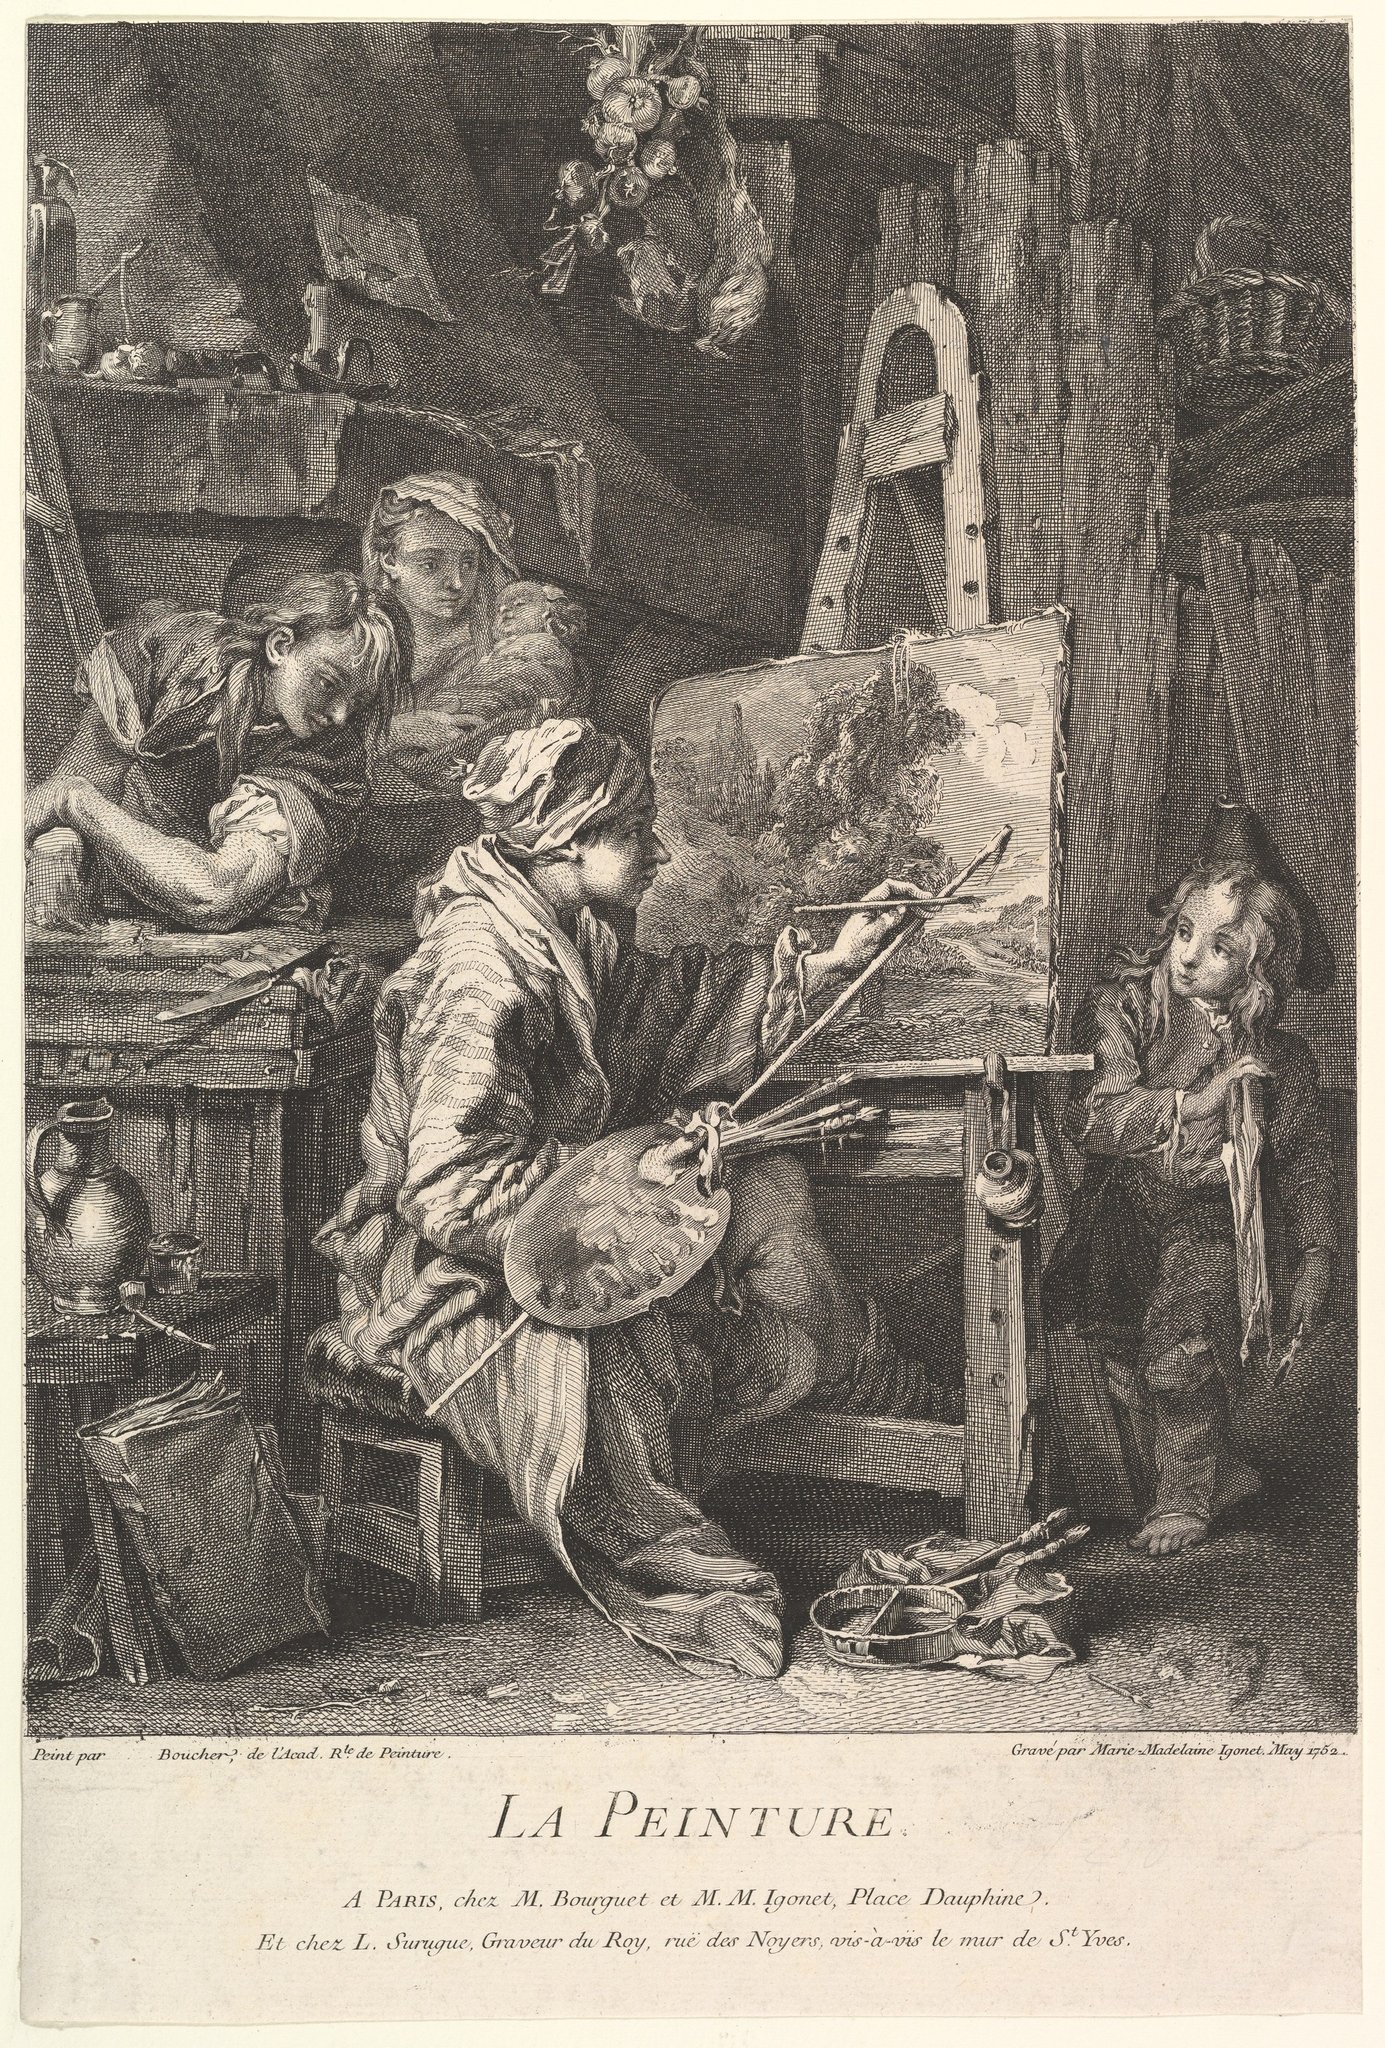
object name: print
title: Painting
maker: marie madeleine igonet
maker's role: artist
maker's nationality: french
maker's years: 1744-1760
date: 1752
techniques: engraving, etching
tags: painting,boys,infants,men,women